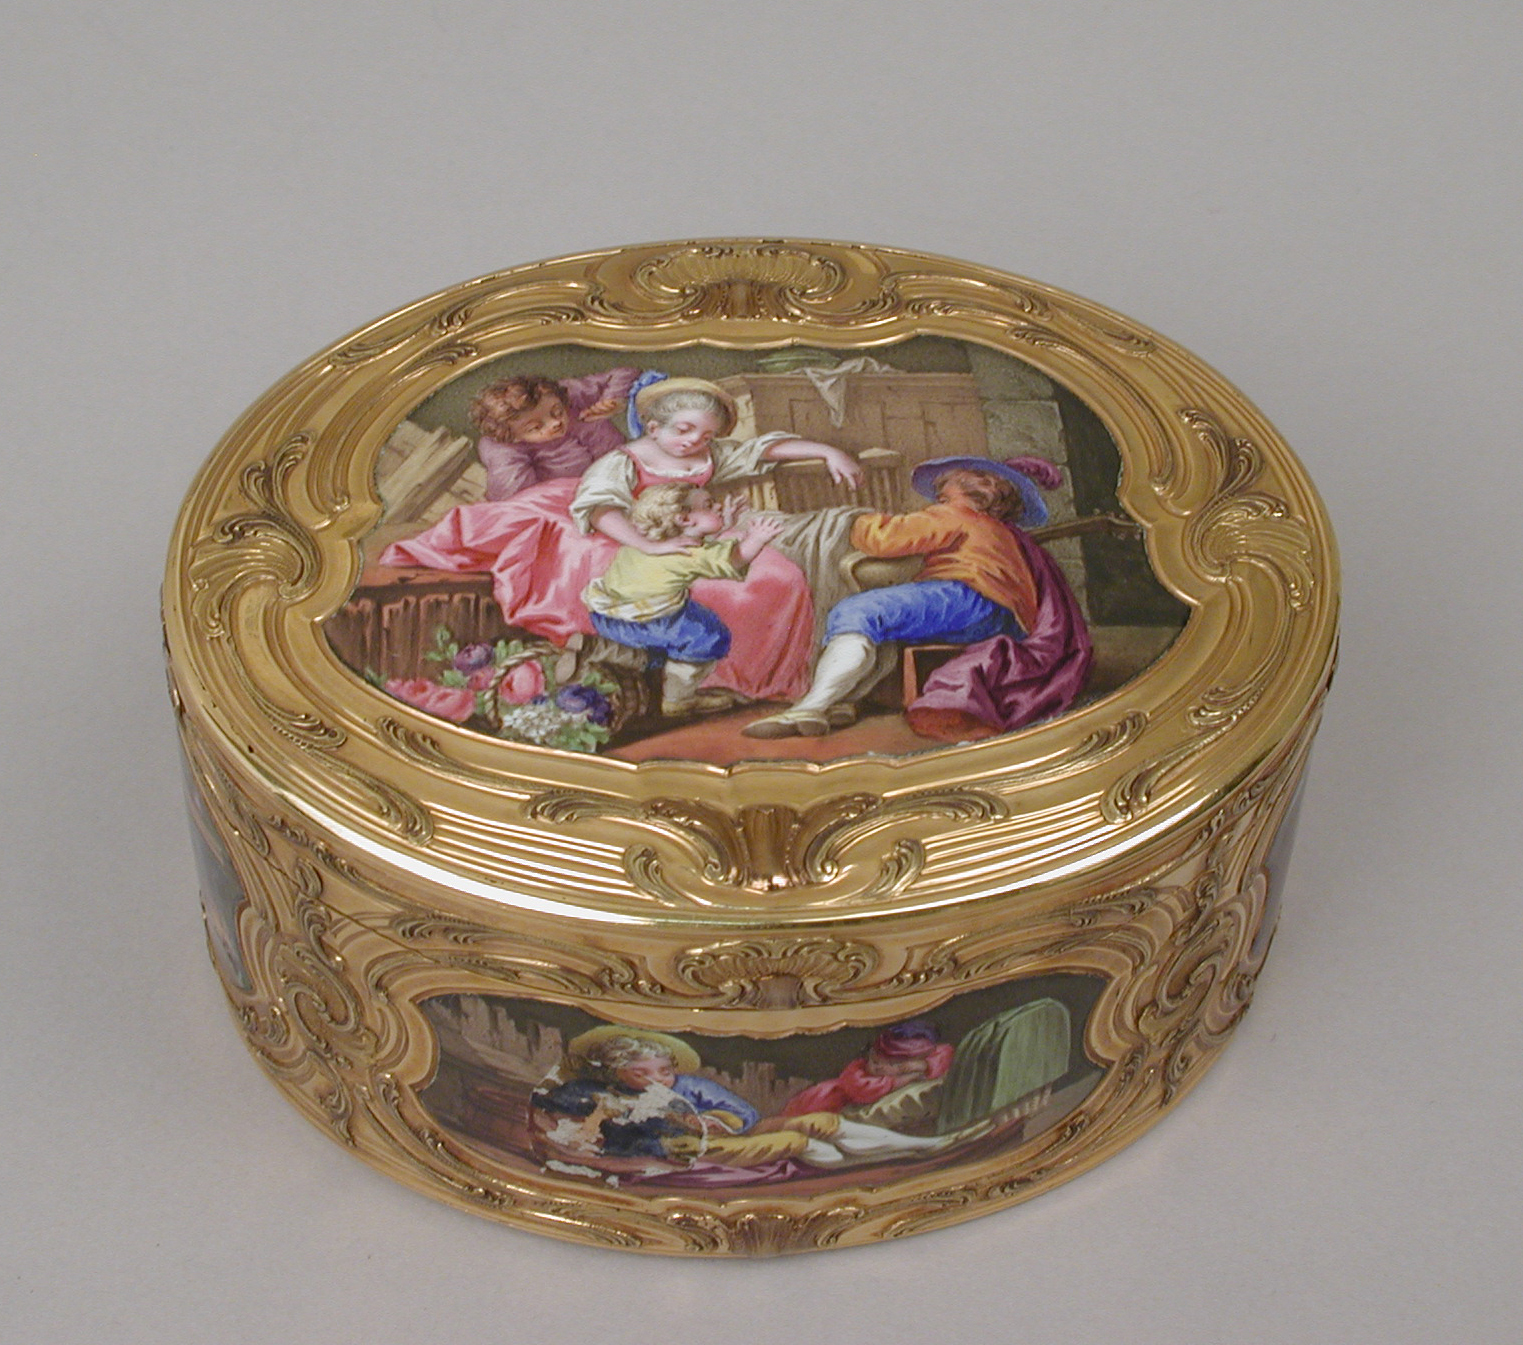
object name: snuffbox, painting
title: Snuffbox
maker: jean-charles-simphorien dubos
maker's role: maker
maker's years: 1719-1819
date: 1759-1760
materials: enamel, gold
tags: girls